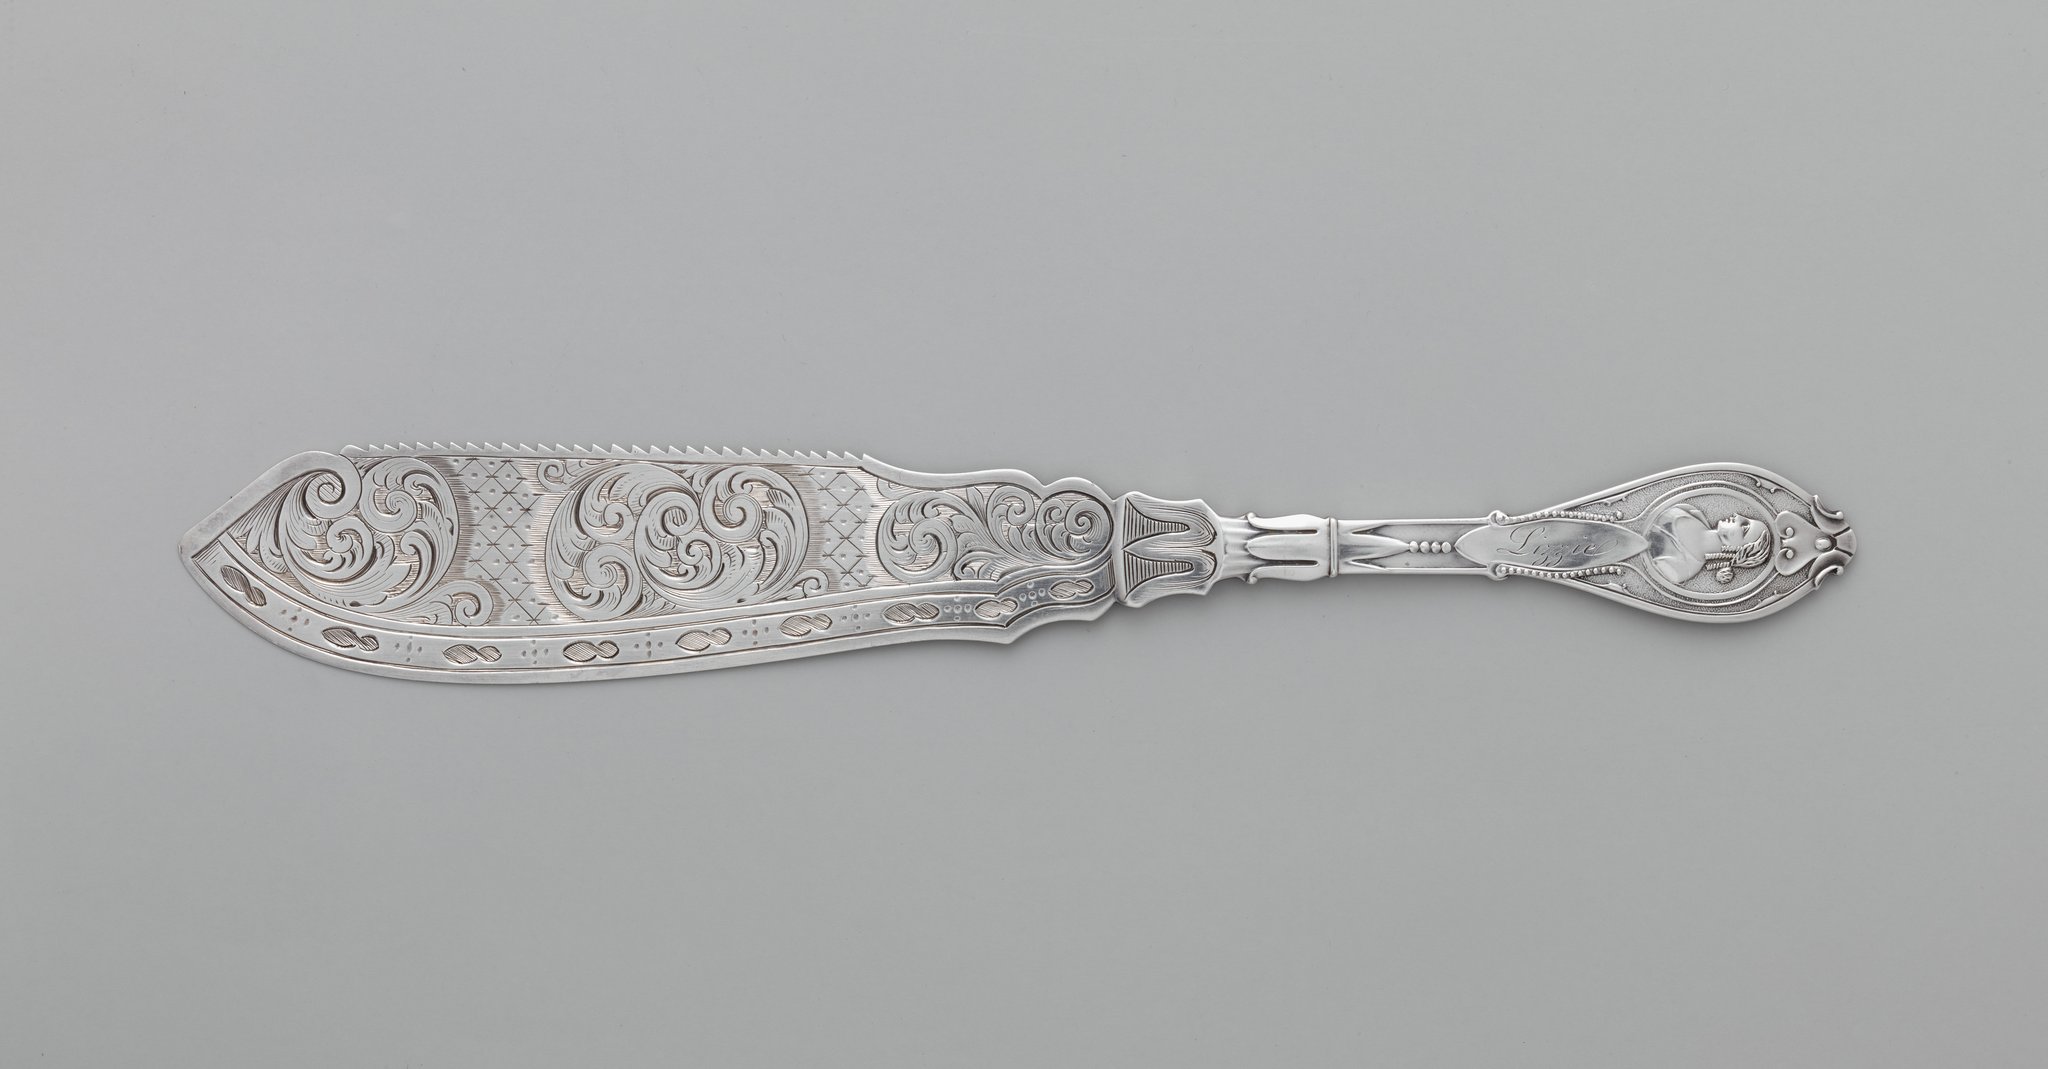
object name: cake saw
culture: american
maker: Anonymous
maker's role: maker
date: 1865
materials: silver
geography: united states